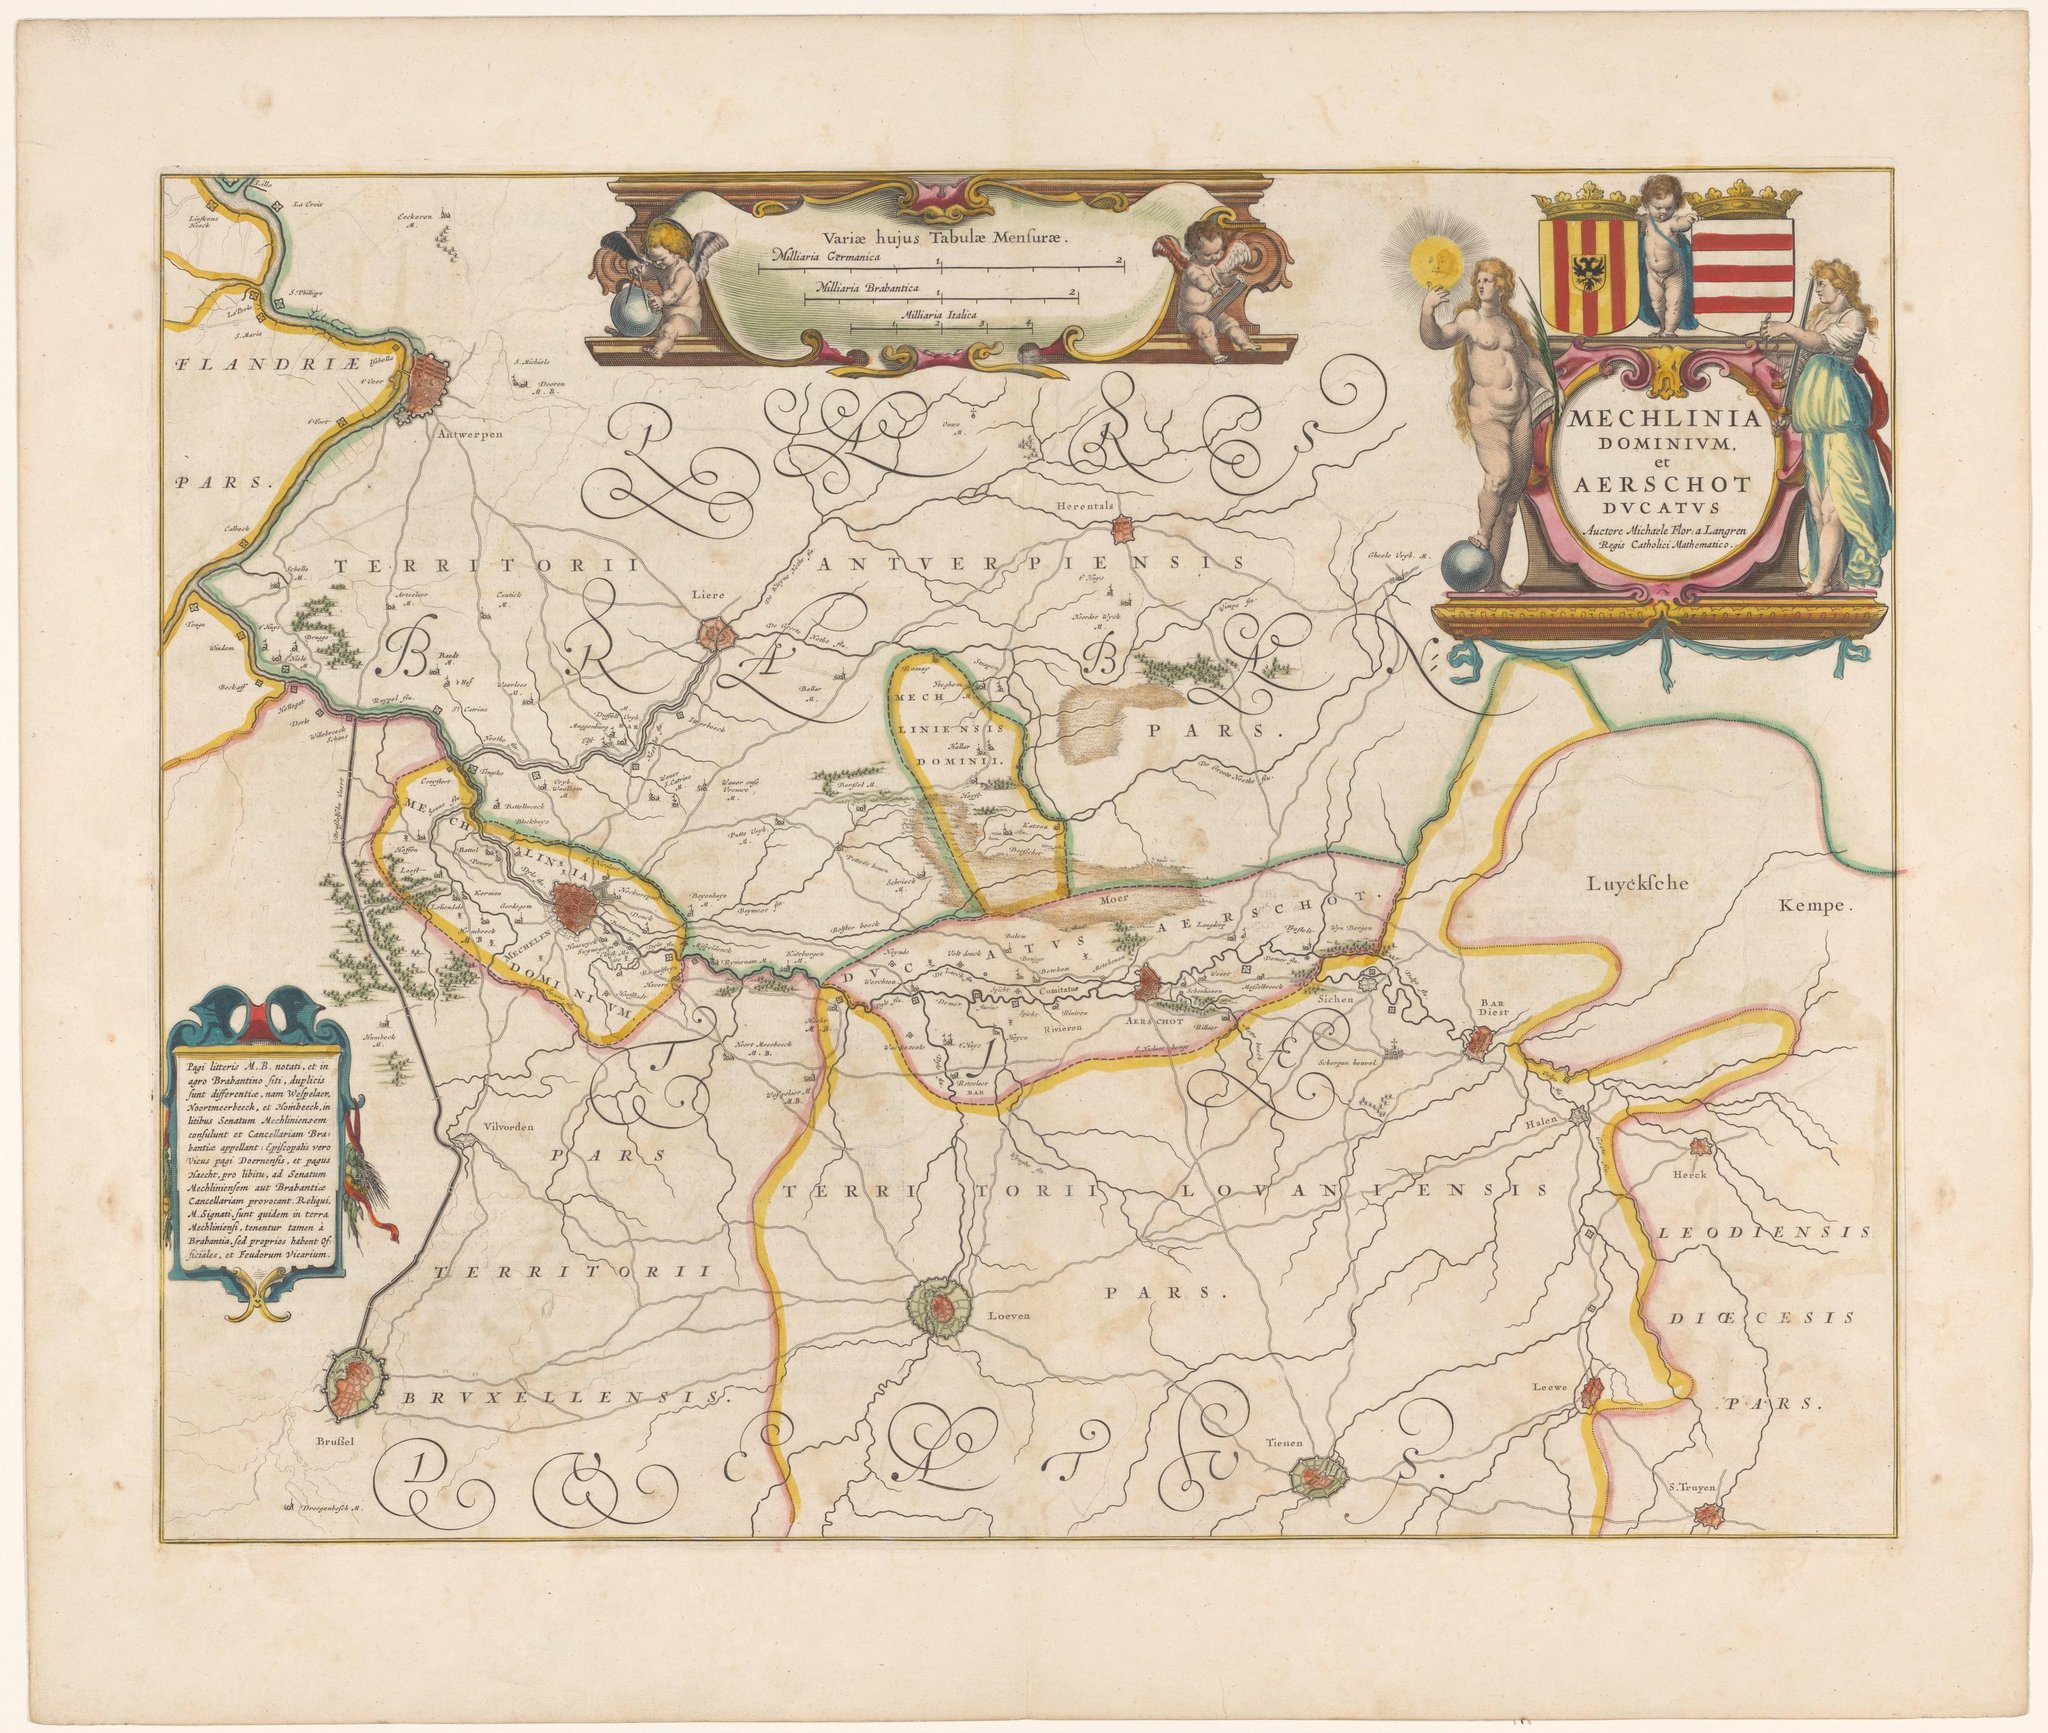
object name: print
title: Kaart van een deel van Vlaanderen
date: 1647-1664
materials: paper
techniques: engraving, etching, hand coloring, letterpress printing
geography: amsterdam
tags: coat of arms (as symbol of the state, etc.) (+ city; municipal), maps of separate countries or regions, justitia (justice) as roman personification, truth; 'verità' (ripa), coat of arms (as symbol of the state, etc.) (+ province; provincial), mechelen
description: Prent gebruikt in: Blaeu, Willem Janszoon en Johannes Willemszoon Blaeu. Toonneel des aerdrycx, ofte nieuwe Atlas, dat is de beschryving van alle landen. 4 delen. Amsterdam: Johannes Willemszoon Blaeu, 1647-1650, dl. 1 (1647-1648). Of in: Blaeu, Willem Janszoon en Johannes Willemszoon Blaeu. Toonneel des aerdrycx, ofte nieuwe Atlas, dat is de beschryving van alle landen. 4 delen. Amsterdam: Johannes Willemszoon Blaeu, 1649-1650, dl. 1 (1649). Of in: Blaeu, Willem Janszoon en Johannes Willemszoon Blaeu. Toonneel des aerdriicx, ofte niuew Atlas, dat is beschryving van alle landen. 6 delen. Amsterdam: Johannes Willemszoon Blaeu, 1658-1661, dl. 1. Of in: Blaeu, Johannes Willemszoon. J. Blaeus grooten atlas oft wereltbeschyving, in welcke 't aerdryck, de zee, en hemel, wort vertoont en beschreven. 9 delen. Amsterdam: Johannes Willlemszoon Blaeu, 1664-1665, dl. 3 (1664).